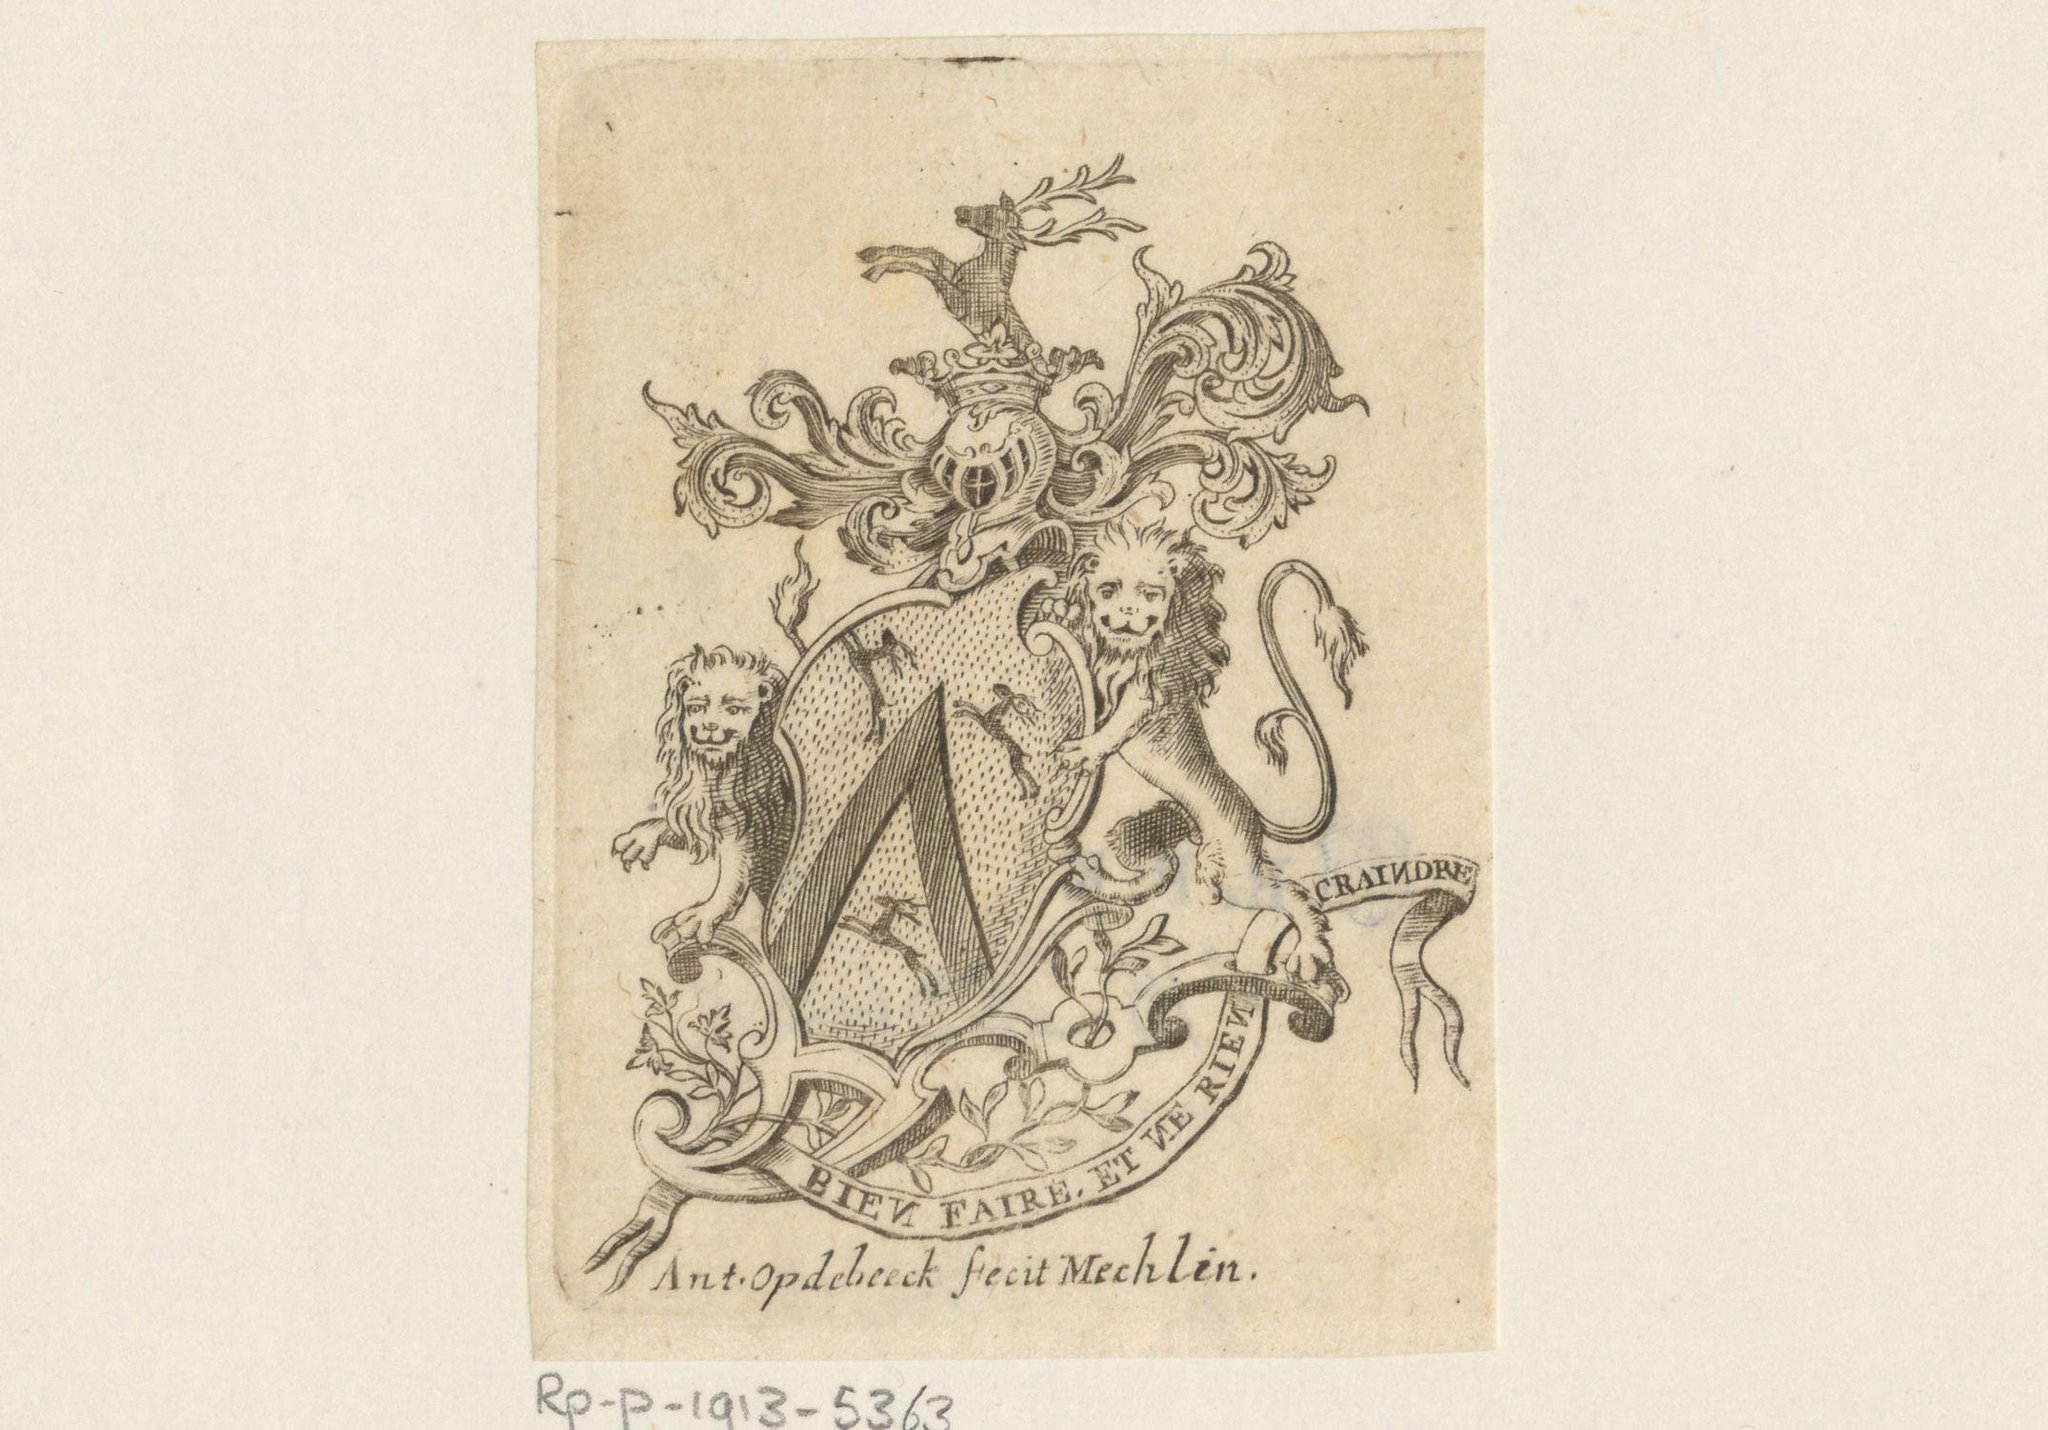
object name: bookplate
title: Ex libris van onbekend, mogelijk De Servais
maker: antoine opdebeeck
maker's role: print maker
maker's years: 1709-1759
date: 1755-1807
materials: paper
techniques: engraving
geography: mechelen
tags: armorial bearing, heraldry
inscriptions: collector's mark: Lugt 2760, collector's mark: Lugt 2233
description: Ex libris van Gaspar-Joseph de Servais (1735-1807).